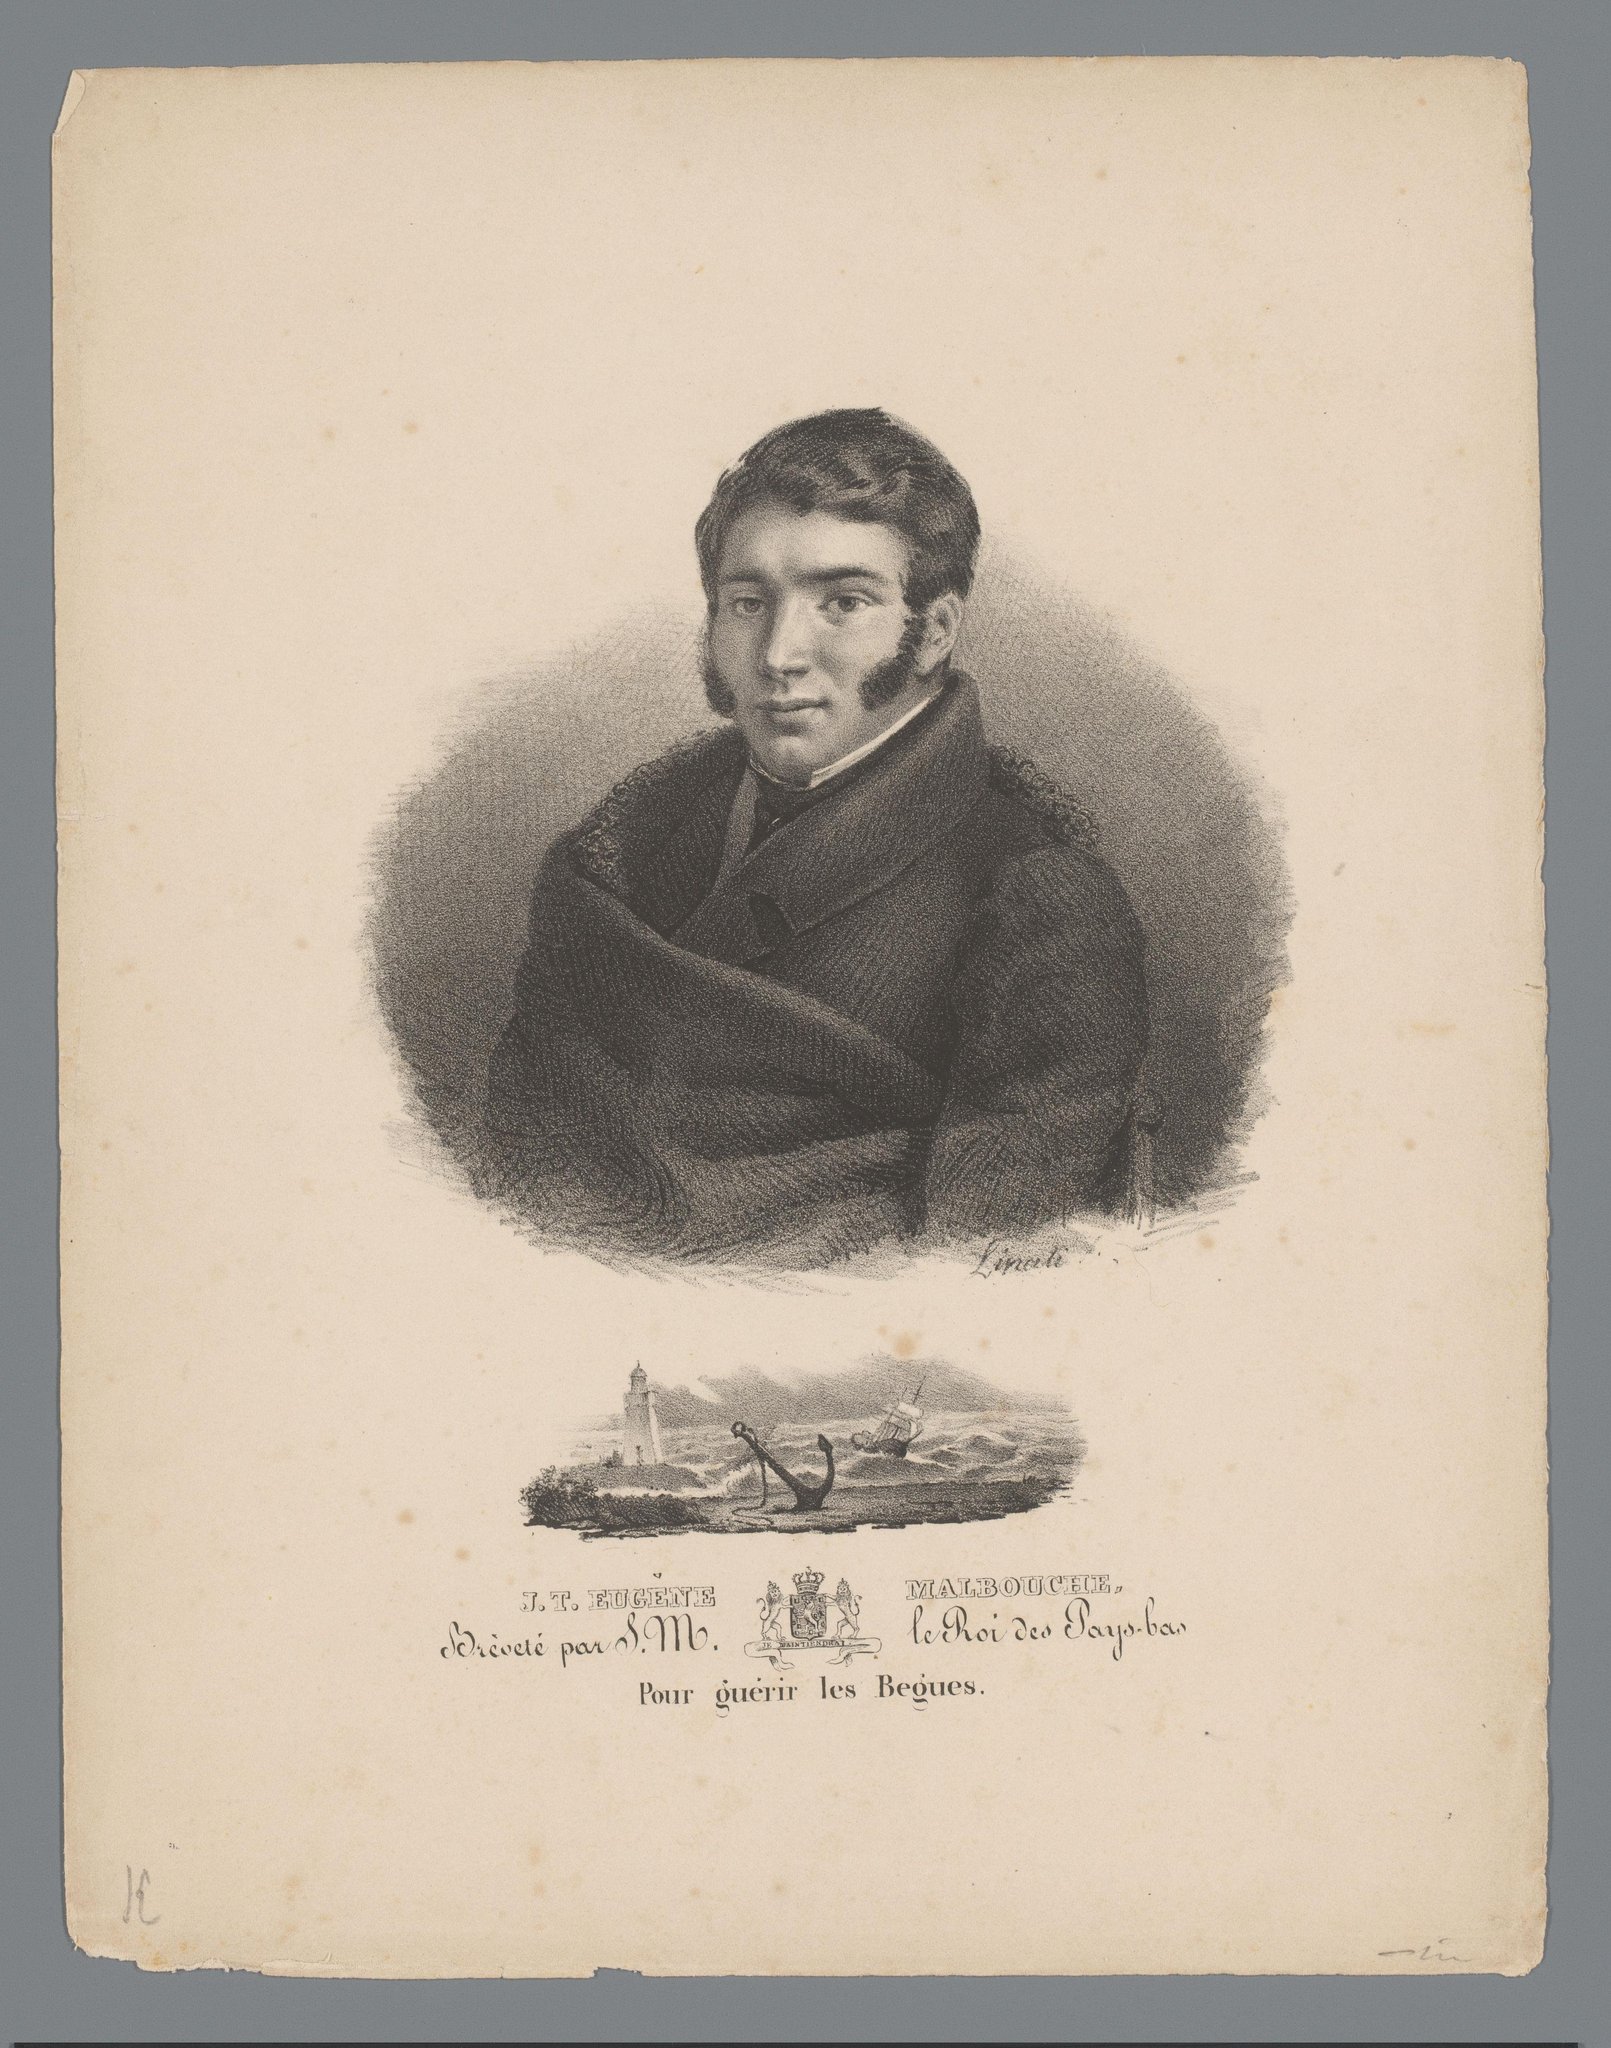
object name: print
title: J.T. Eugène Malbouche, bréveté par S.M. le roi des Pays-Bas pour guérir les Begues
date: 1800-1832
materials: paper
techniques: lithograph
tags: sideburns, adult man, historical persons, sea (seascape)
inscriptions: collector's mark: Lugt 2228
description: Onder het portret een voorstelling met een schip op woeste zee nabij een vuurtoren en drieregelig onderschrift.